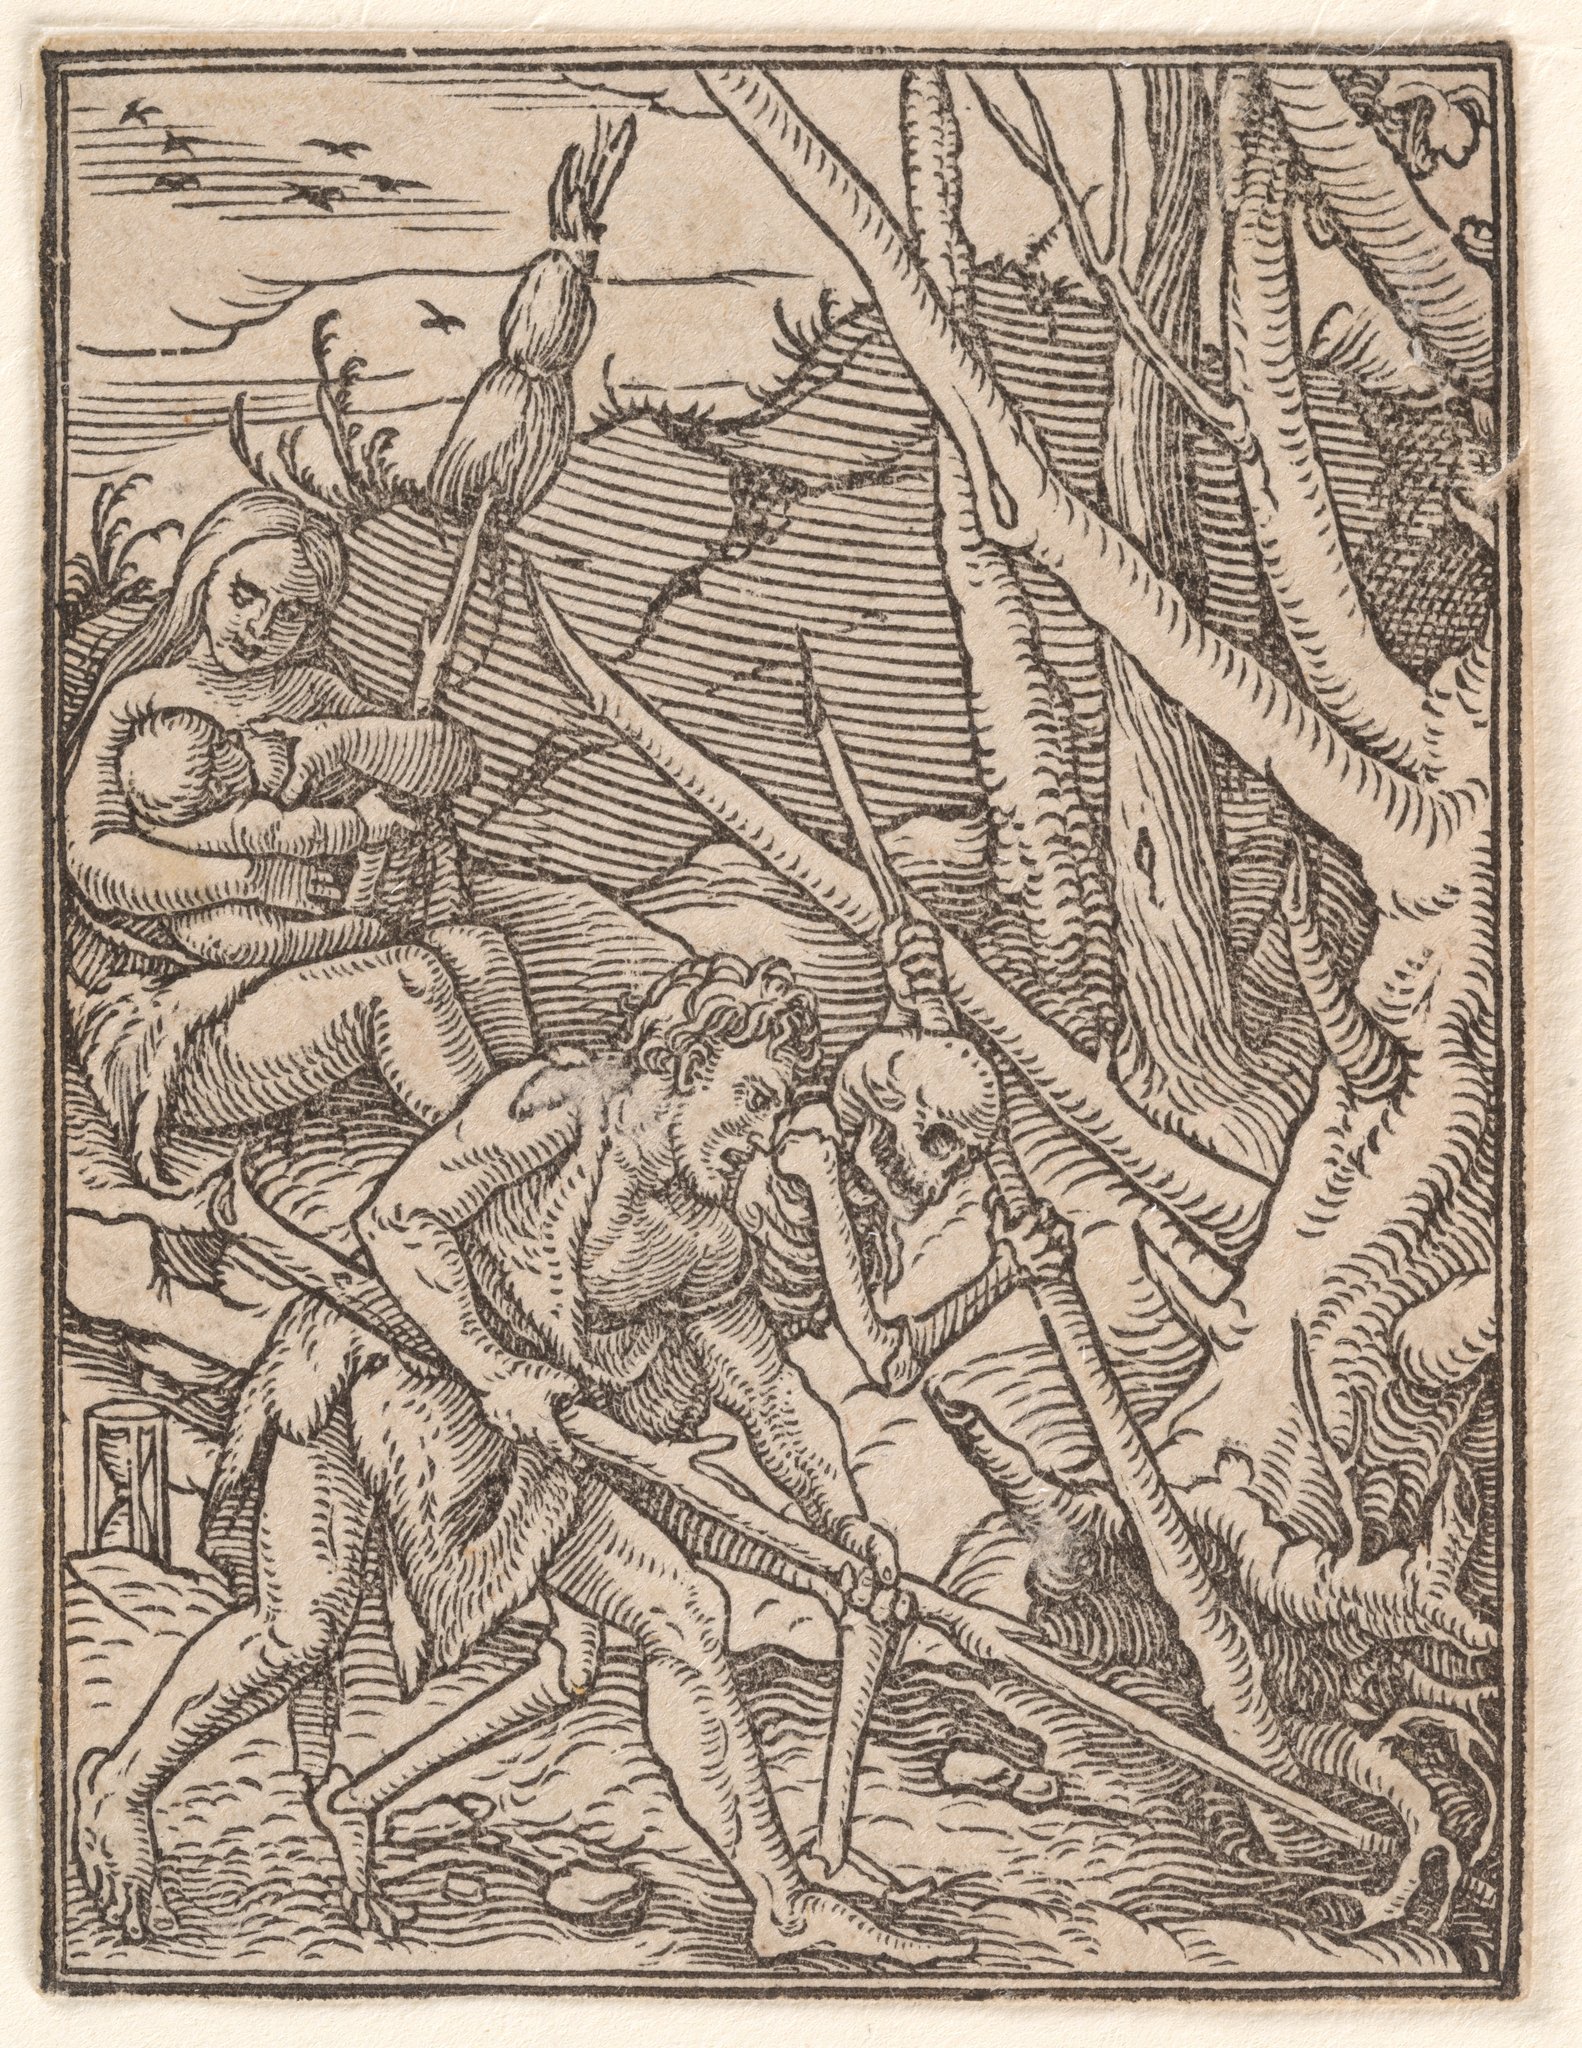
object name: print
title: Adam Ploughing, from "The Dance of Death"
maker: hans holbein the younger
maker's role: artist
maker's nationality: german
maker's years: 1497-1543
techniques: woodcut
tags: skeletons,infants,women,adam,nursing